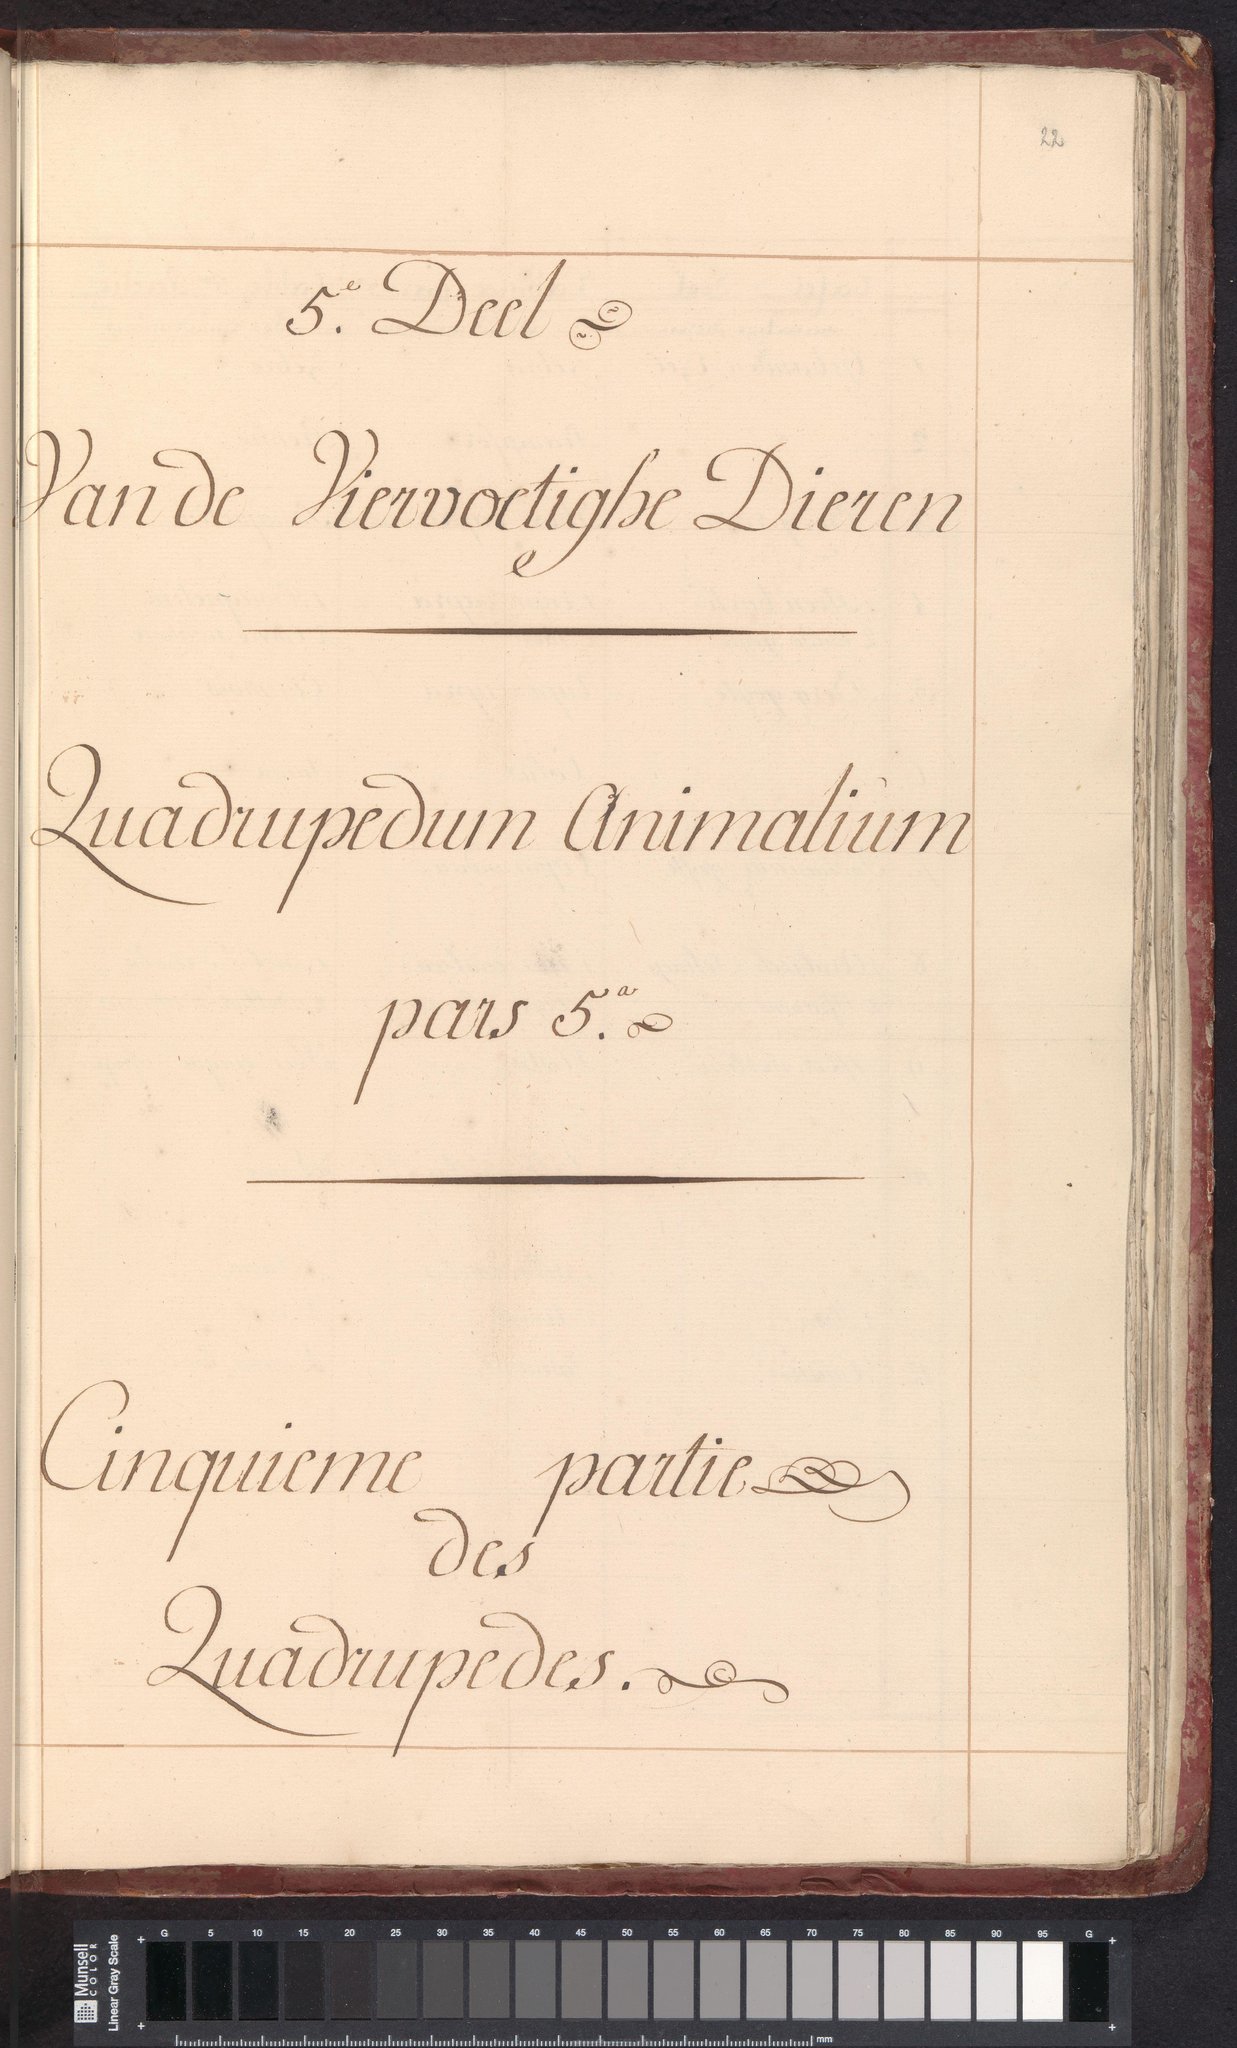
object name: manuscript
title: 5e. Deel Van de Viervoetighe Dieren / Quadrupedum Animalium pars 5a. / Cinquieme partie des Quadrupedes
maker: joseph van huerne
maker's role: kunstliefhebber, mecenas, verzamelaar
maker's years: 1752-1844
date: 1809-1814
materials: ink, paper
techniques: handwriting, pen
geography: bruges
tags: handwriting, written text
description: Handgeschreven titelpagina voor het vijfde deel van de voorstellingen van viervoeters. Onderdeel van het tweede album met tekeningen van viervoeters. Tweede van twaalf albums met tekeningen van dieren, vogels en planten bekend rond 1600, gemaakt in opdracht van keizer Rudolf II. Met toelichting in Nederlands, Latijn en Frans.